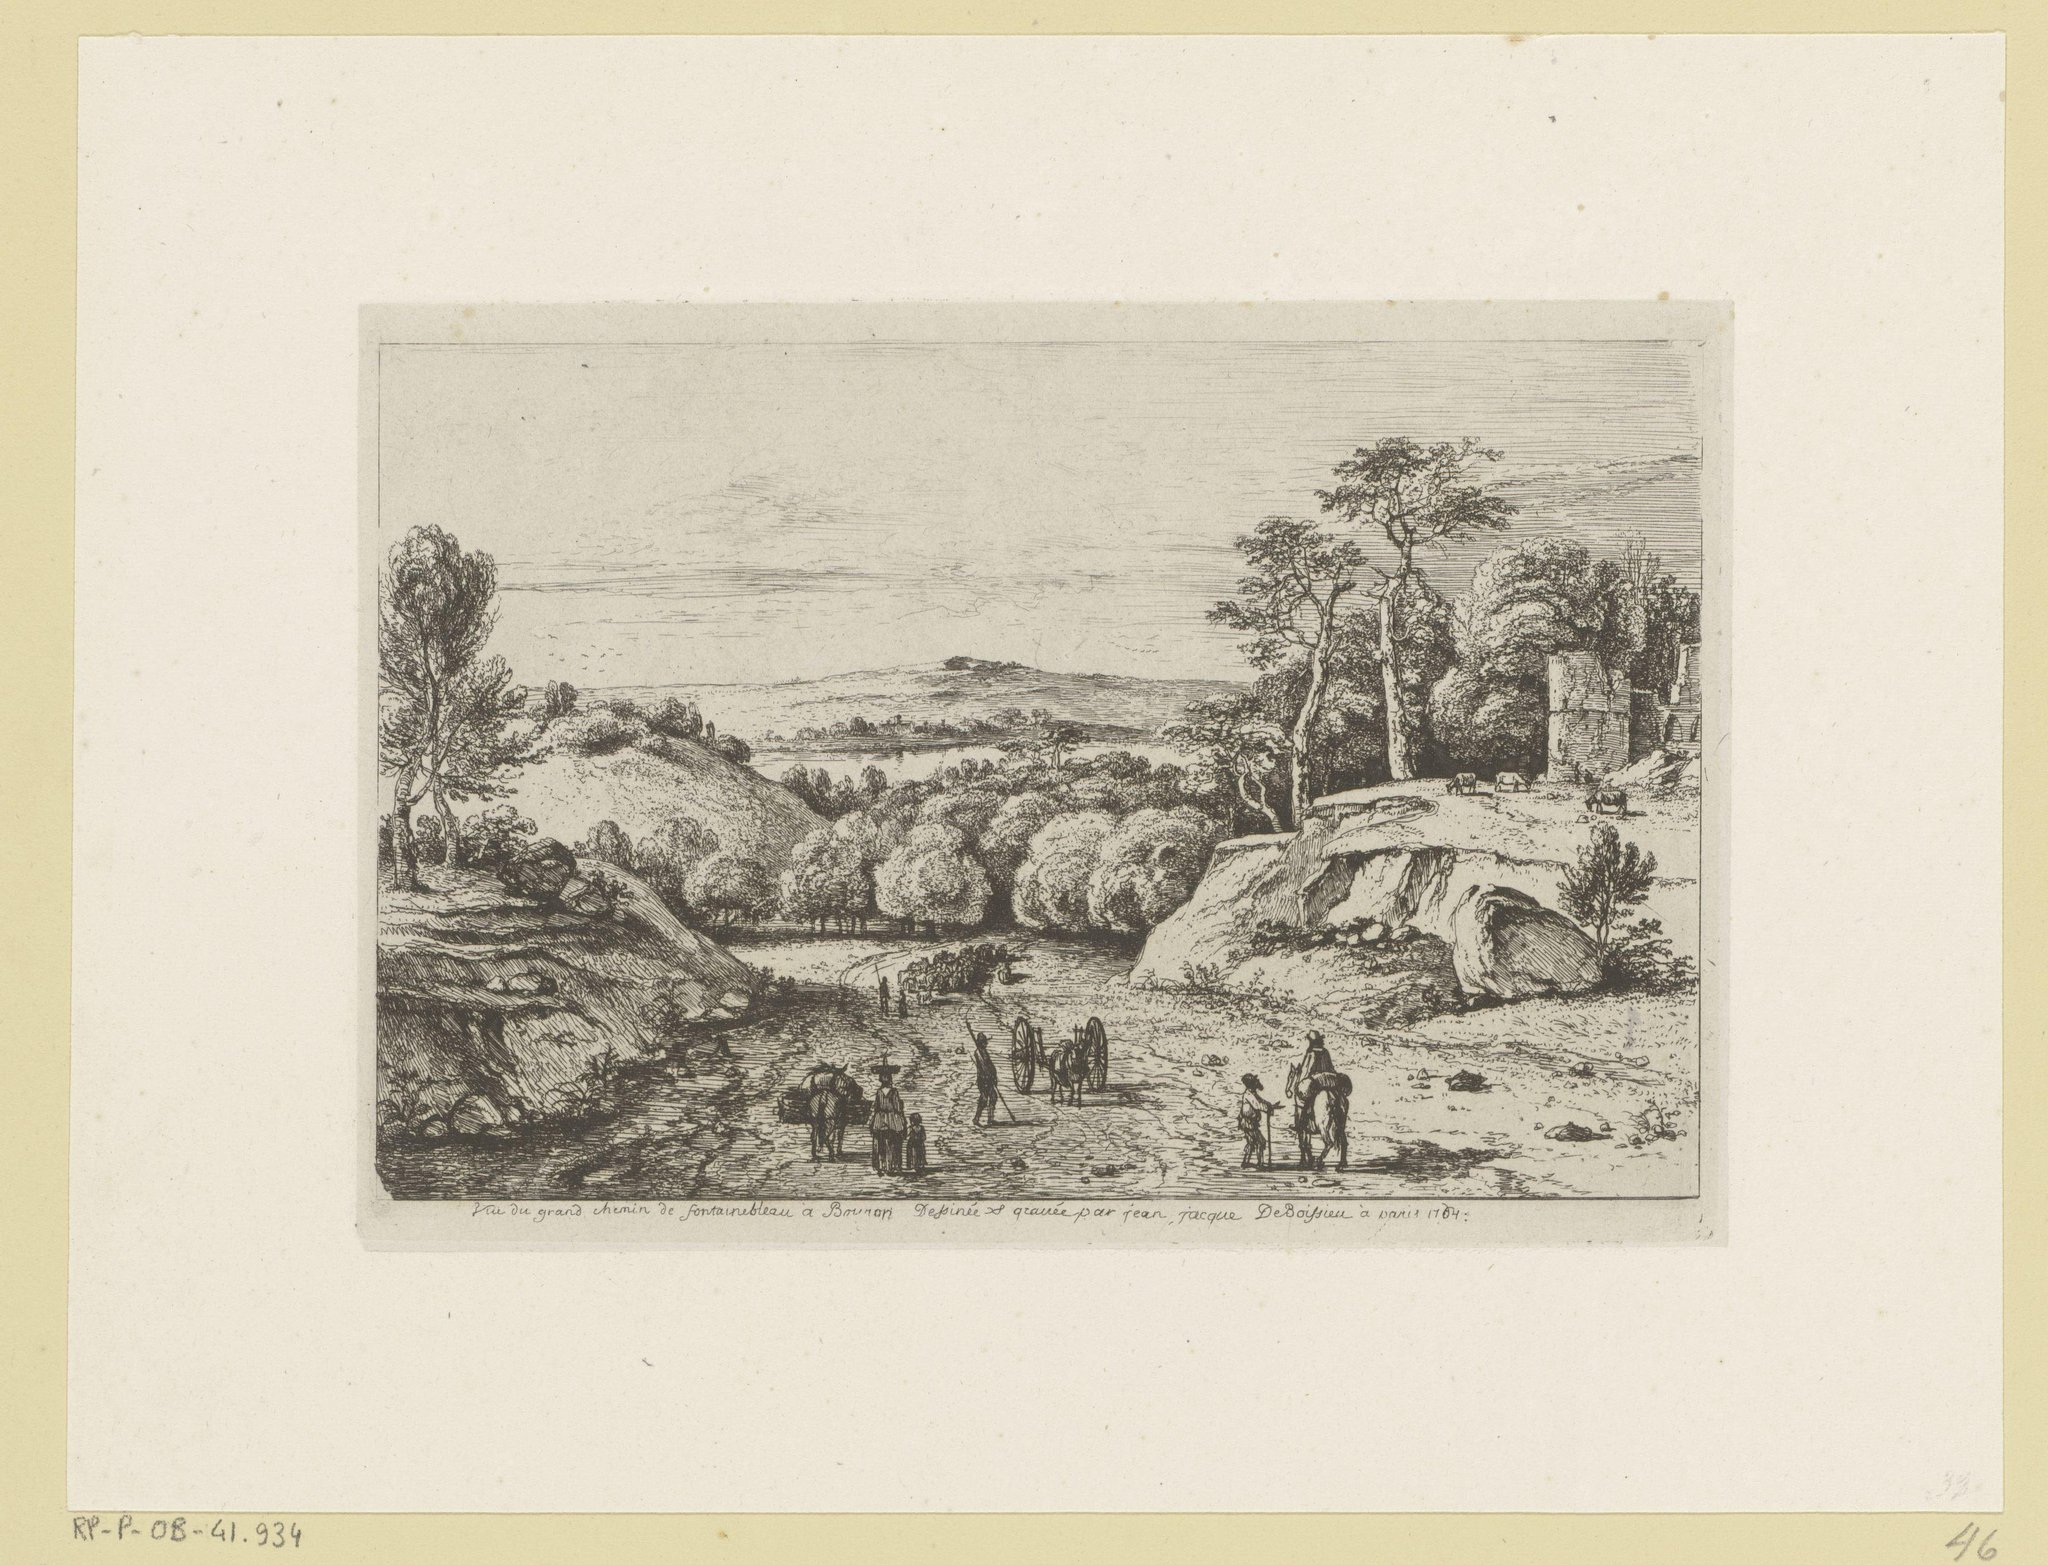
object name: print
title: Gezicht op de weg van Fontainebleau naar Bourron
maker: jean jacques de boissieu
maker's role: draughtsman, print maker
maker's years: 1736-1810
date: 1764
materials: paper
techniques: drypoint, etching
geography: paris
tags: landscapes (+ landscape with figures, staffage), public road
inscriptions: collector's mark: Lugt 12